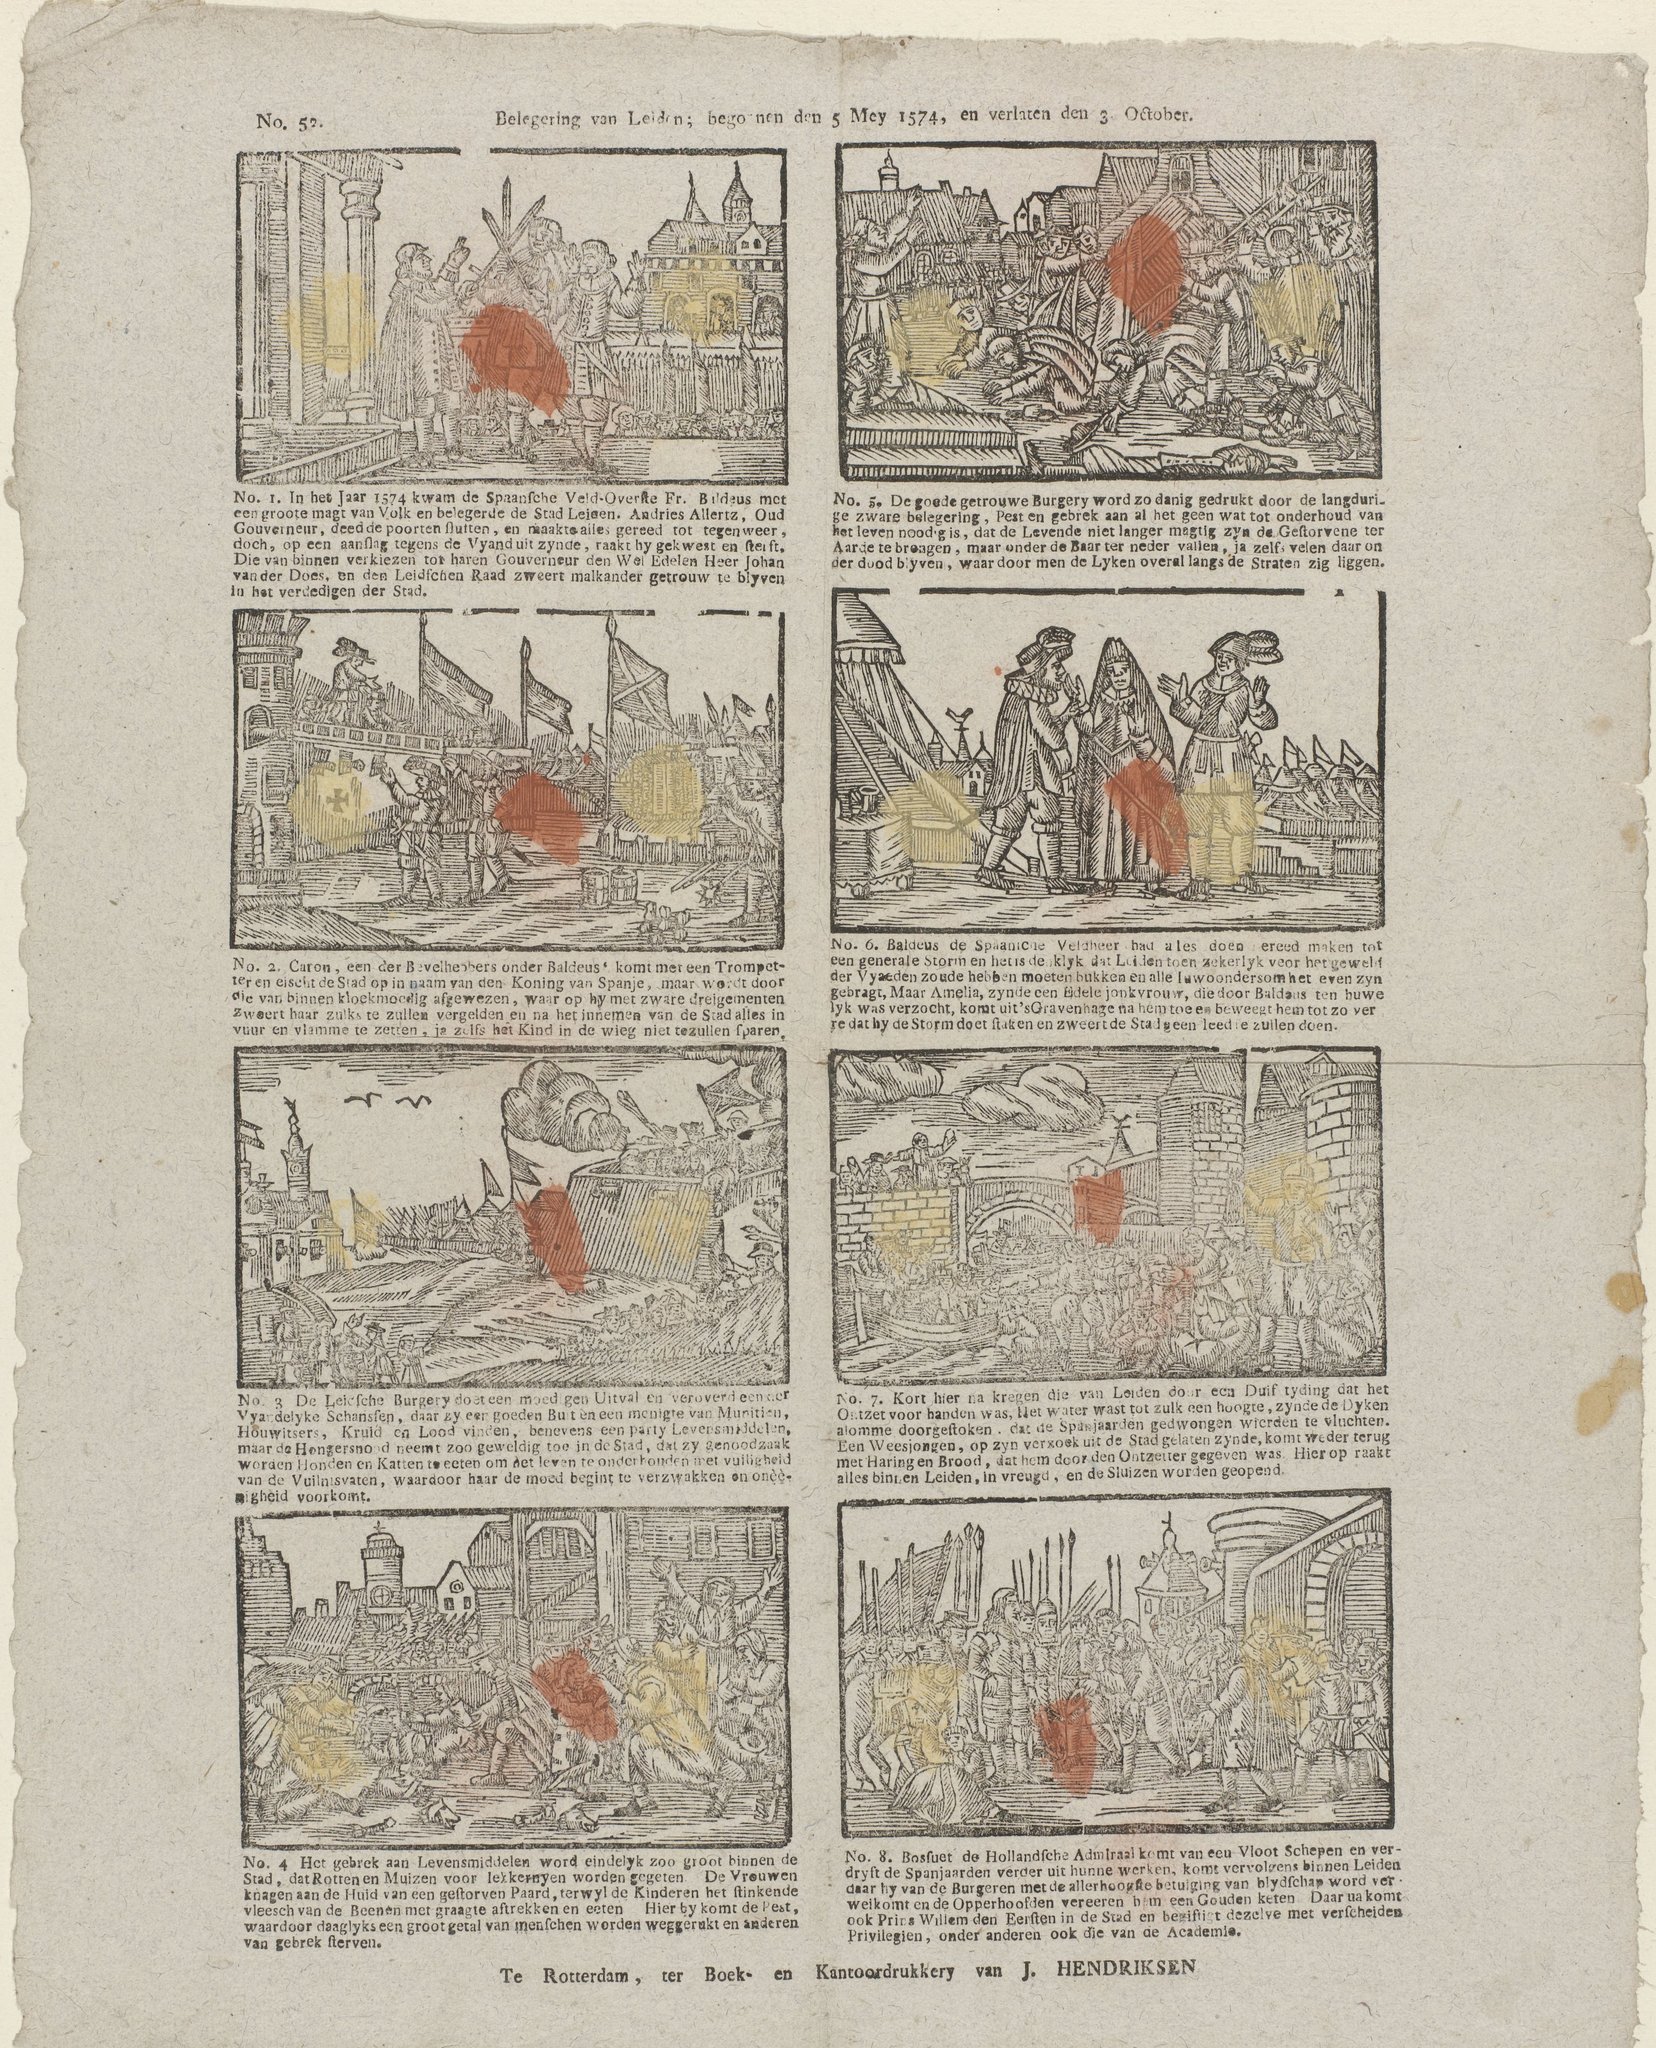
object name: print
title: Belegering van Leiden; begonnen den 5 Mey 1574, en verlaten den 3 October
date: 1781-1828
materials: paper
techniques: colour, letterpress printing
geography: rotterdam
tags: history, siege, leiden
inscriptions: collector's mark: Lugt 2228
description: Blad met 8 voorstellingen over het beleg en ontzet van Leiden. Onder elke afbeelding een onderschrift. Genummerd linksboven: No. 52.